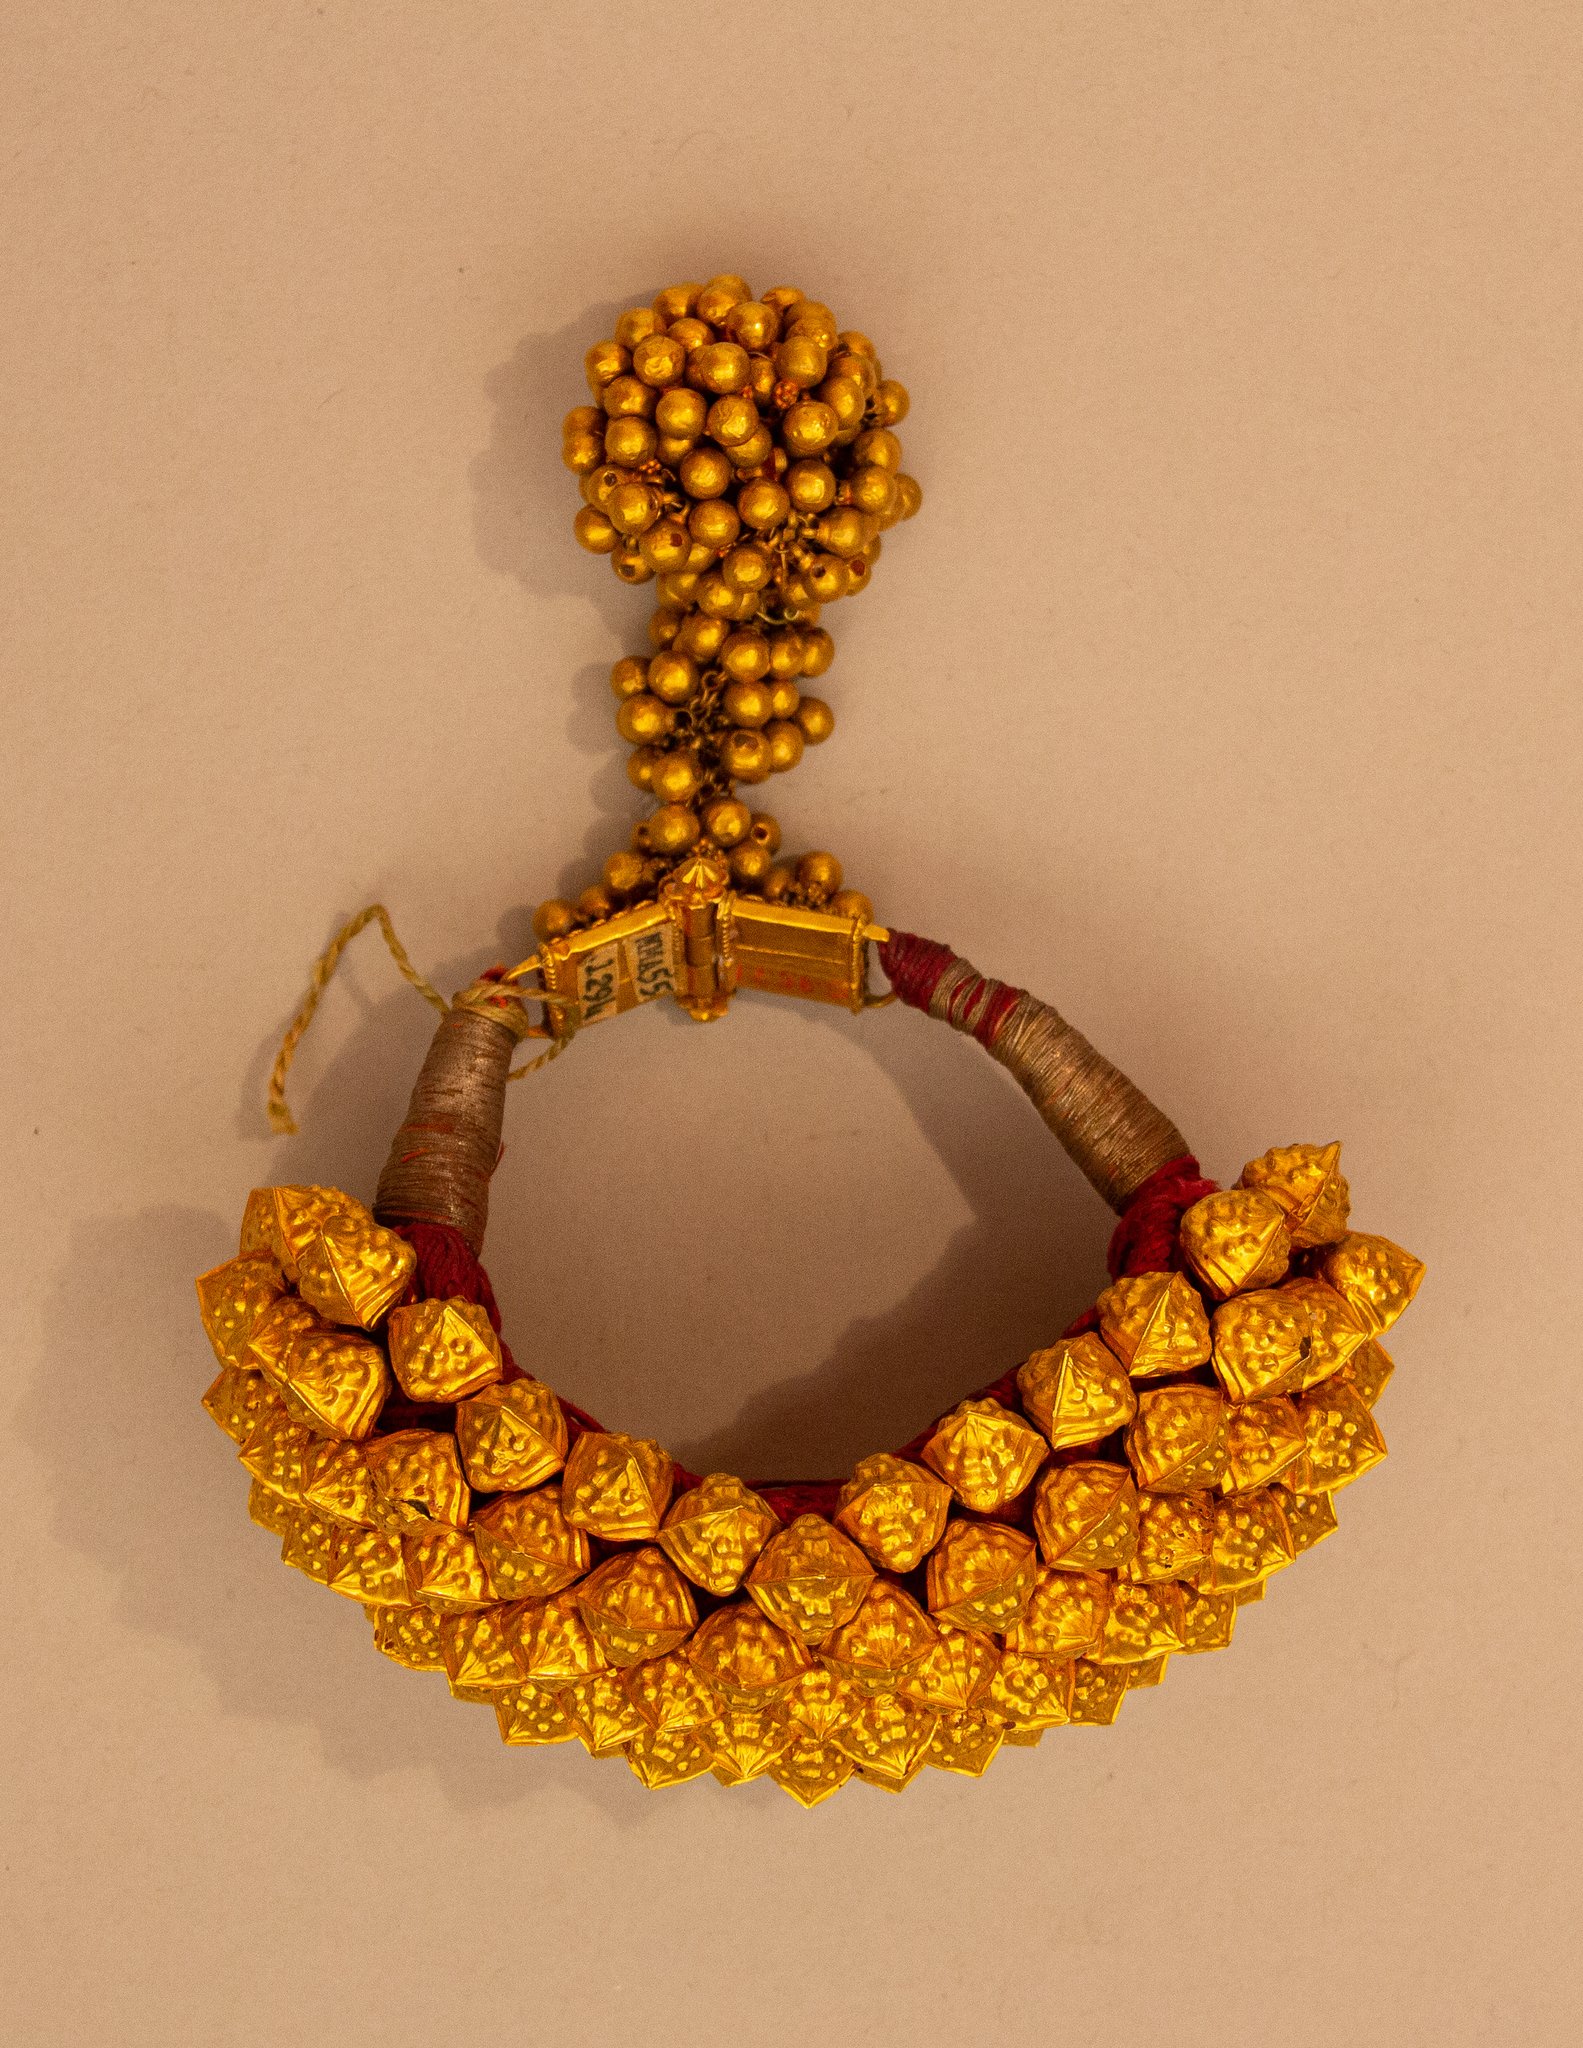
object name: armband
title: Armband (Bazuband)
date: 1801-1900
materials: gold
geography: india